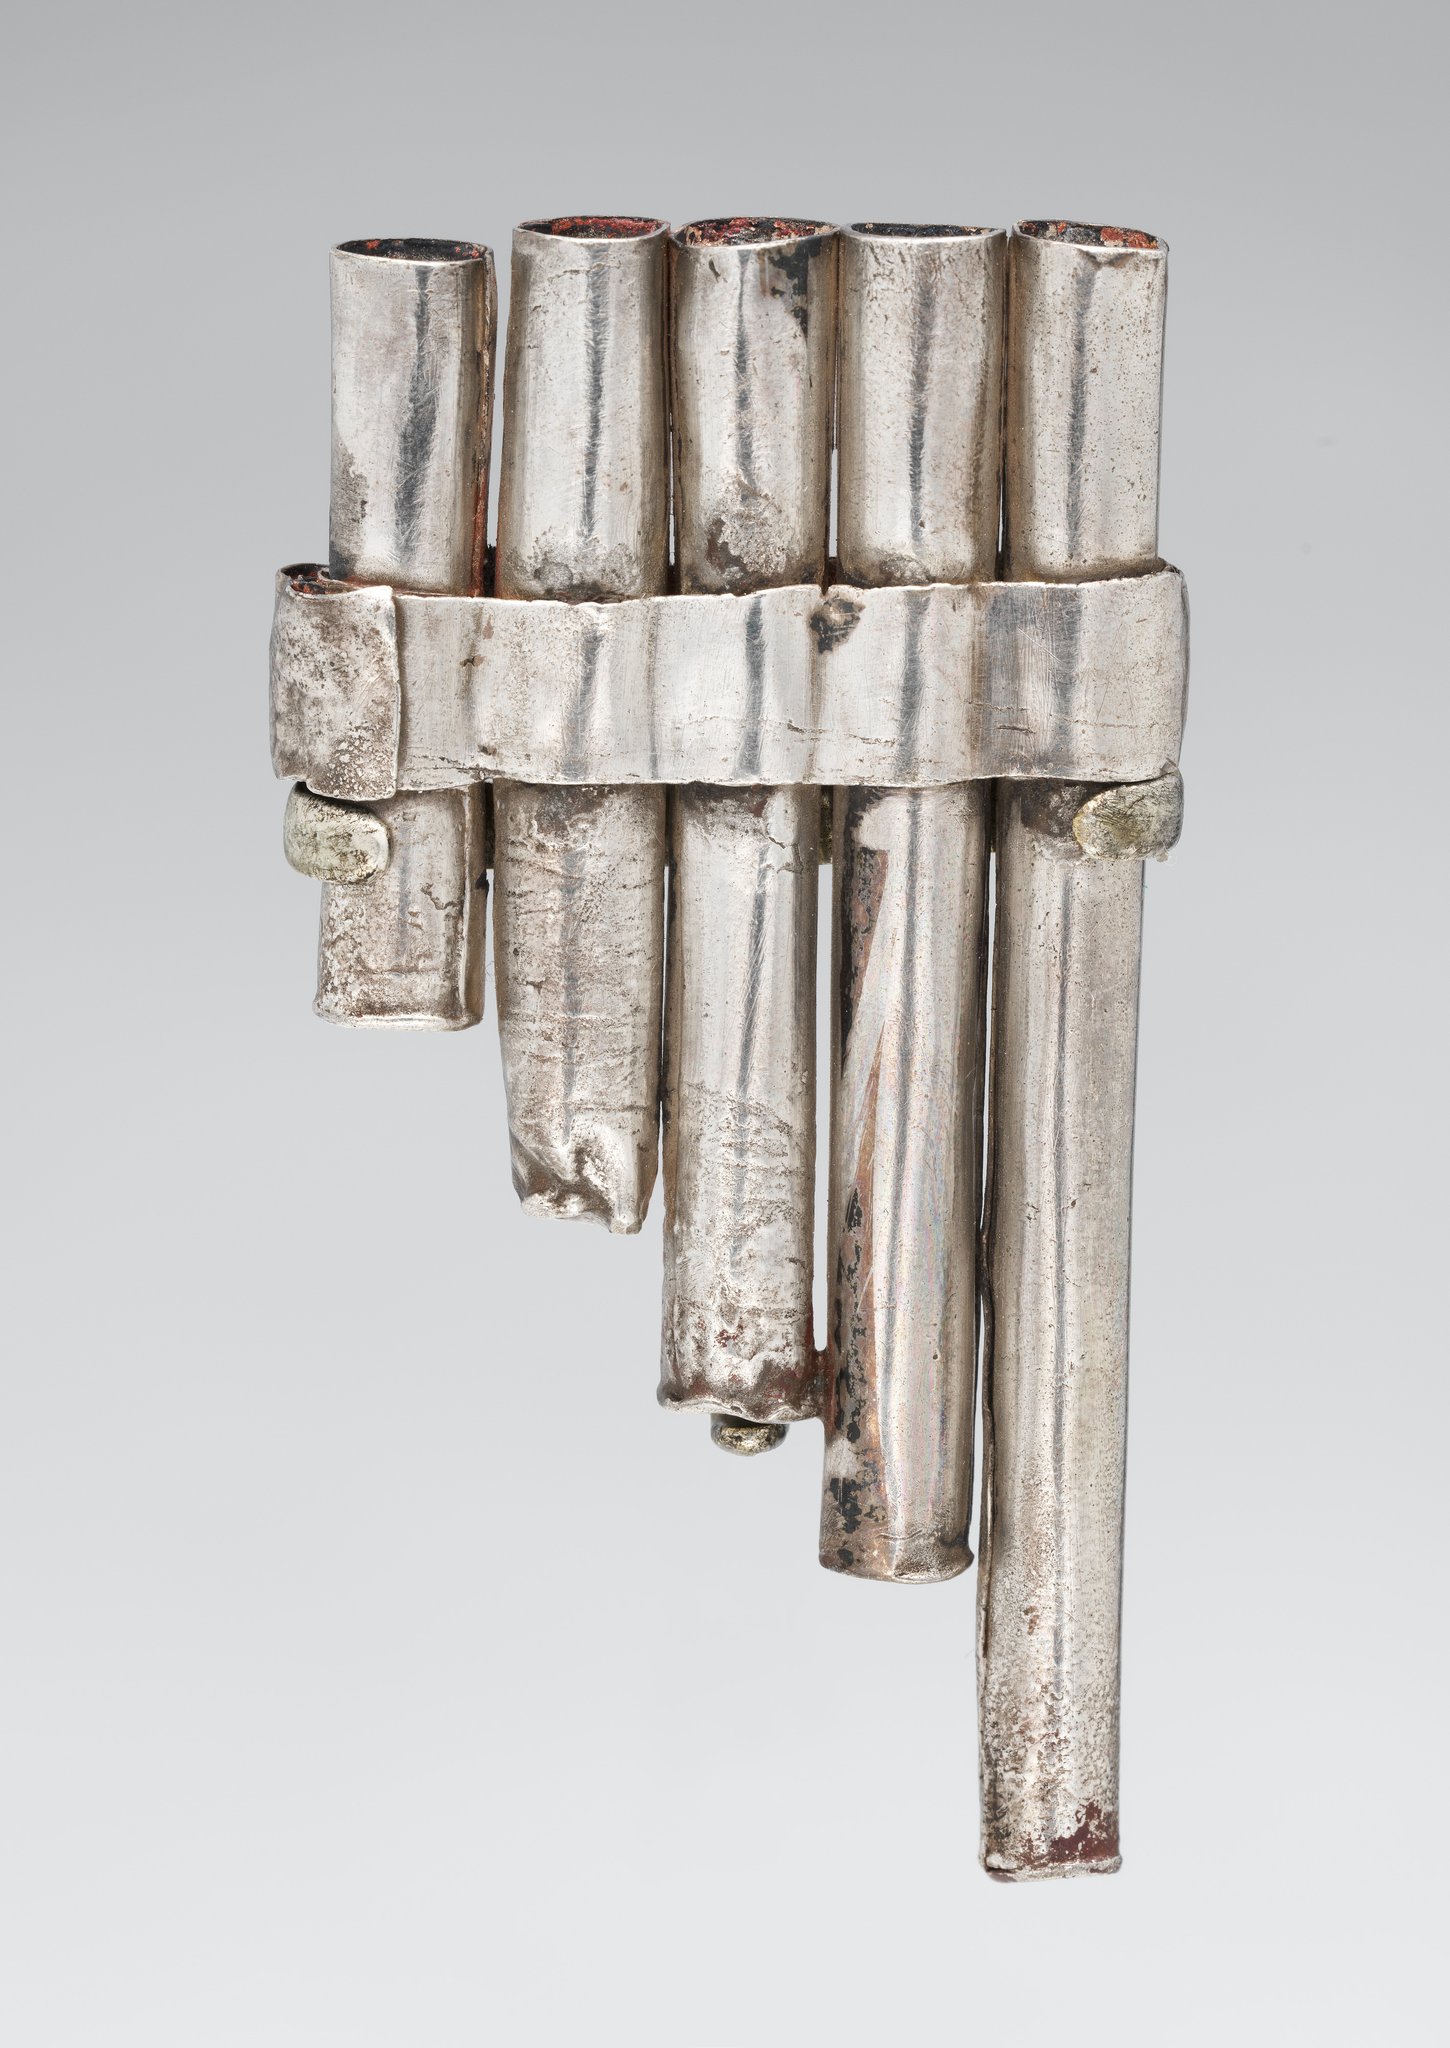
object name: miniature panpipe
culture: chancay or chimú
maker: chimú or chancay artist(s)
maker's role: artist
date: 1300-1470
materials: silver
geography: peru